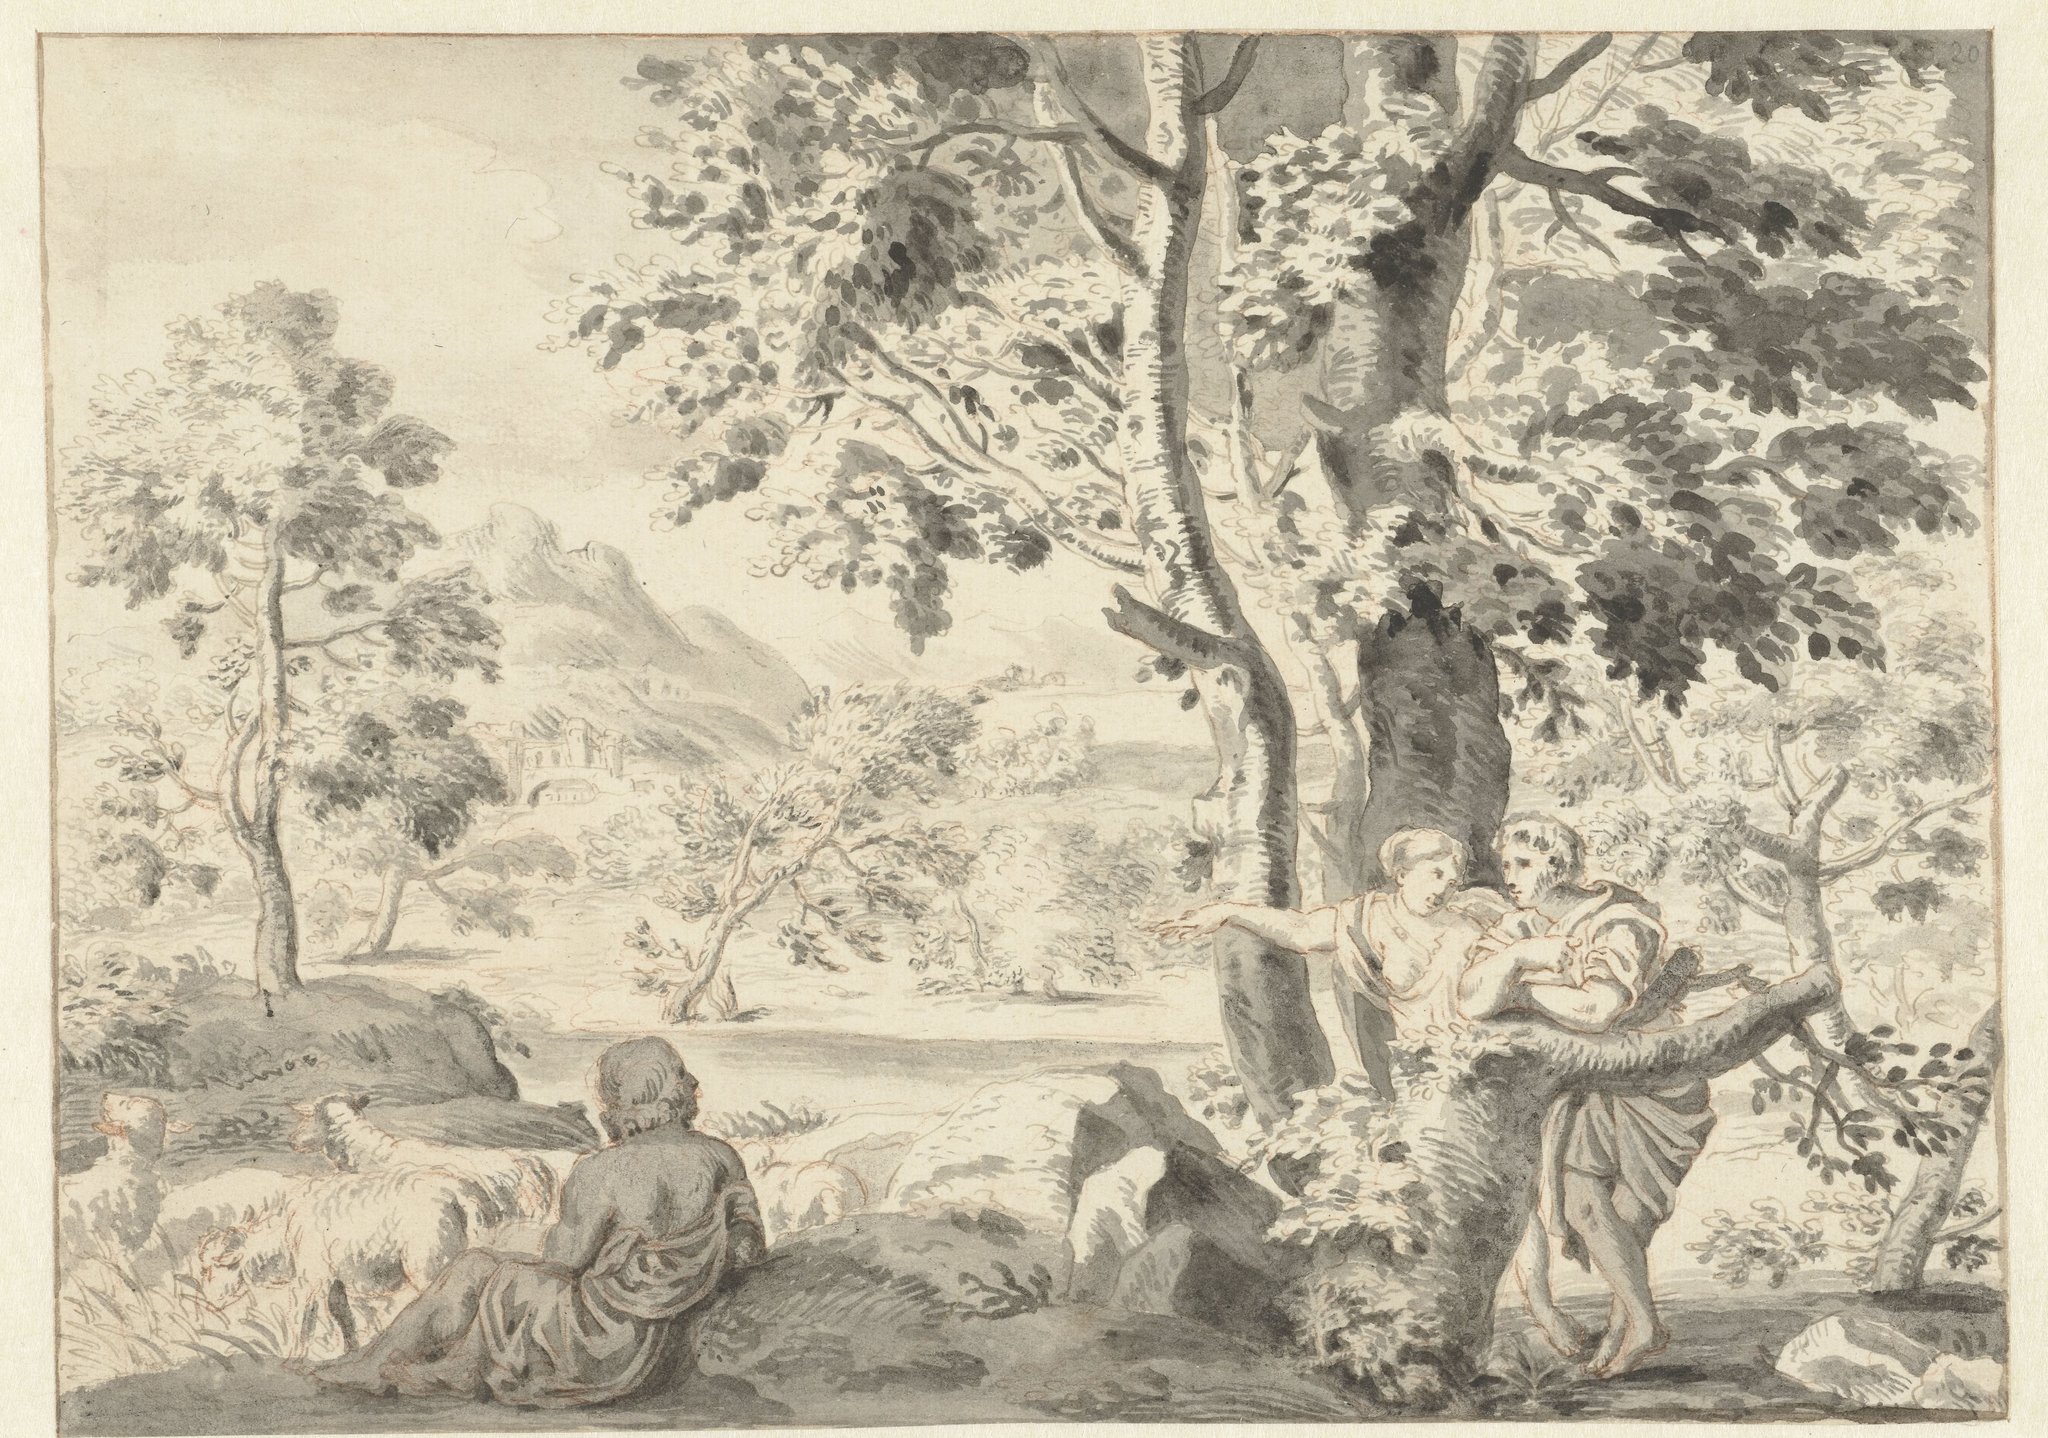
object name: drawing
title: Bomenrijk landschap met een herder, een man en een vrouw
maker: gerrit grasdorp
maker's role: draughtsman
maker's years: 1659-1716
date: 1661-1693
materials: ink, paper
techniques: brush, pen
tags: herding, herdsman, herdswoman, shepherd, shepherdess, cowherd, etc., landscapes in the temperate zone